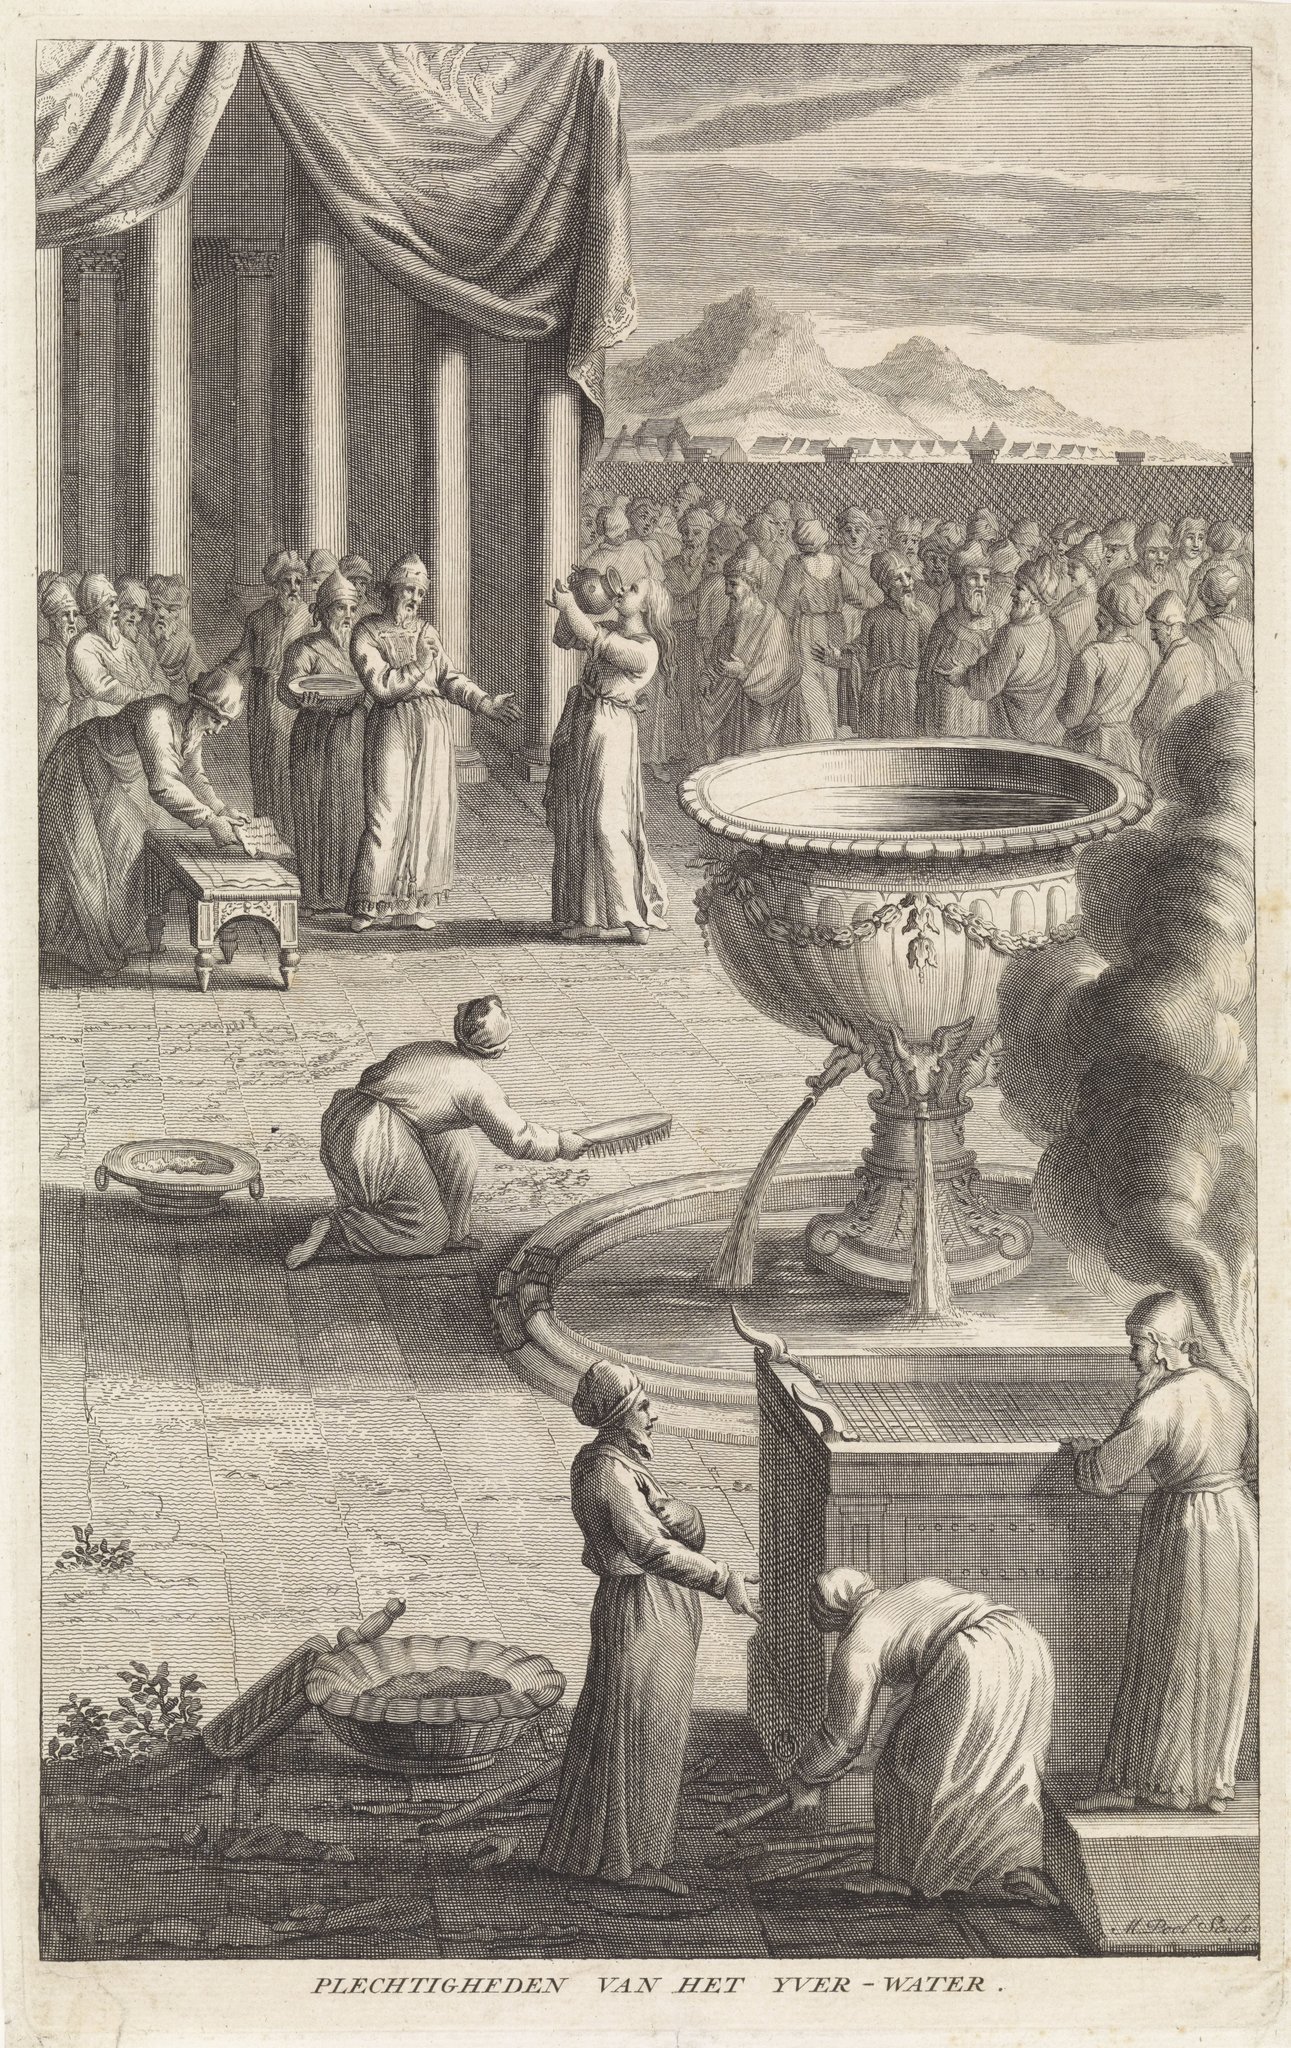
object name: print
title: Ceremonie met van overspel verdachte vrouwen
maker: matthijs pool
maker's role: print maker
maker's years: 1676-1740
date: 1686-1727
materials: paper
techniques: engraving, etching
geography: amsterdam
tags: ordealing an adulterous woman (jewish law)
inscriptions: collector's mark: Lugt 2228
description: Tijdens een ceremonie drinkt een vrouw uit een grote kelk. Tegenover haar staat de hogepriester. De mannen uit de gemeenschap kijken toe. Op de voorgrond wordt op een altaar geofferd. Dit is de Joodse ceremonie die de trouw van een getrouwde vrouw test (Num. 5:11-35).